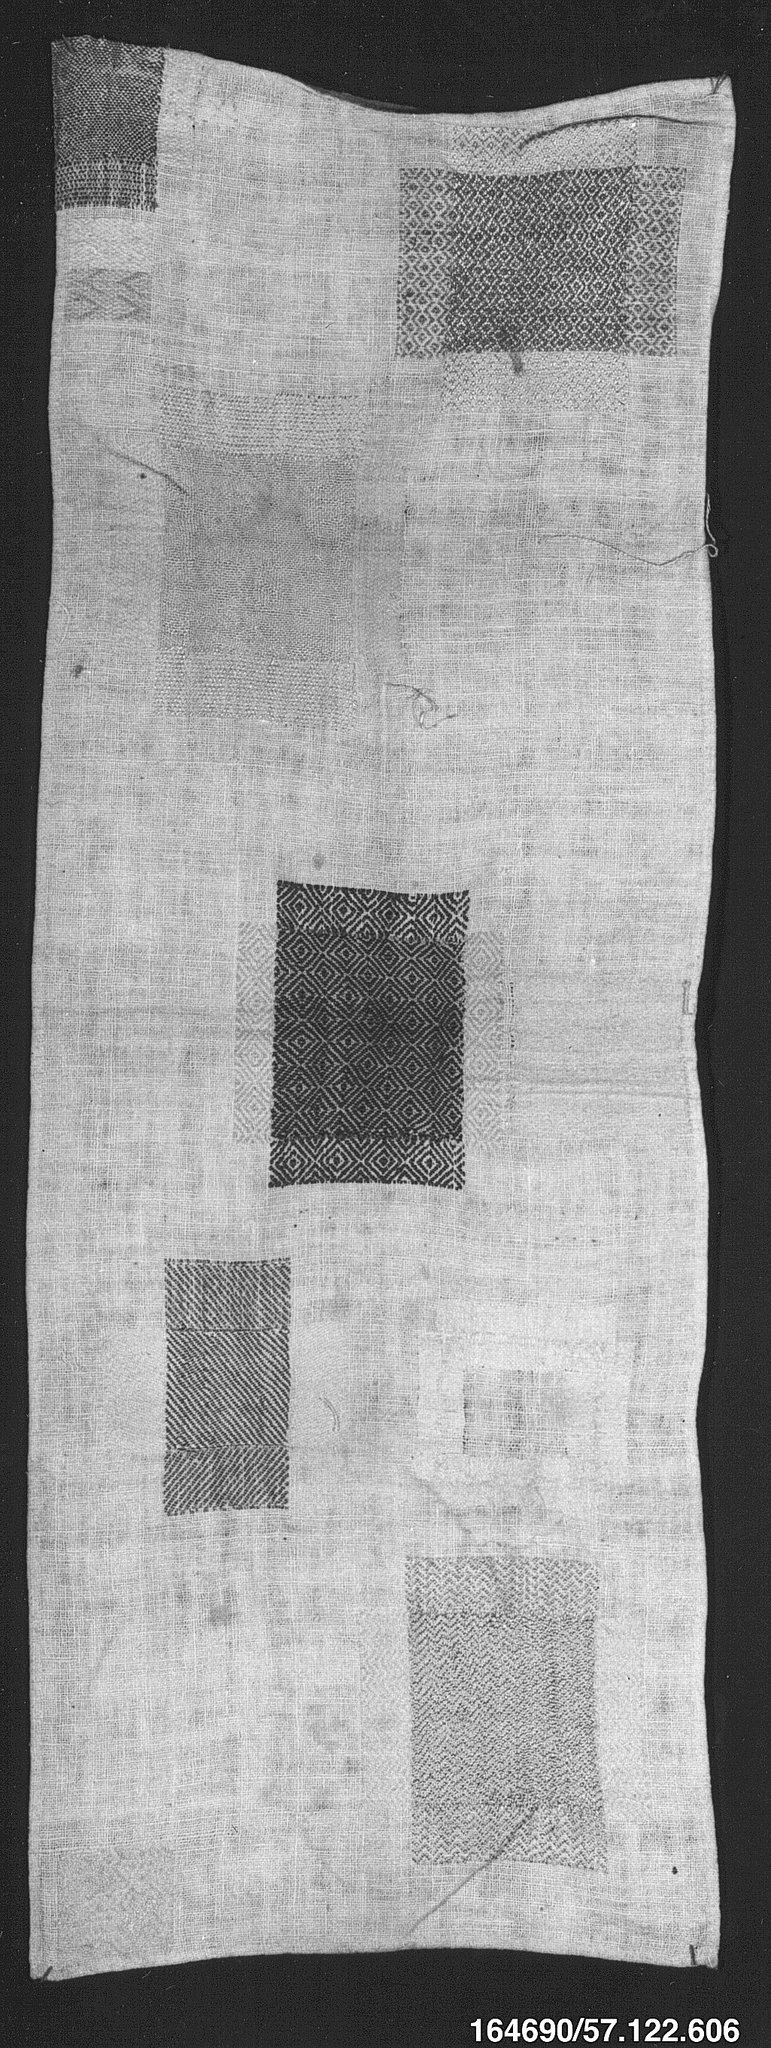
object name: sampler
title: Embroidered darning sampler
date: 1701-1800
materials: linen, silk